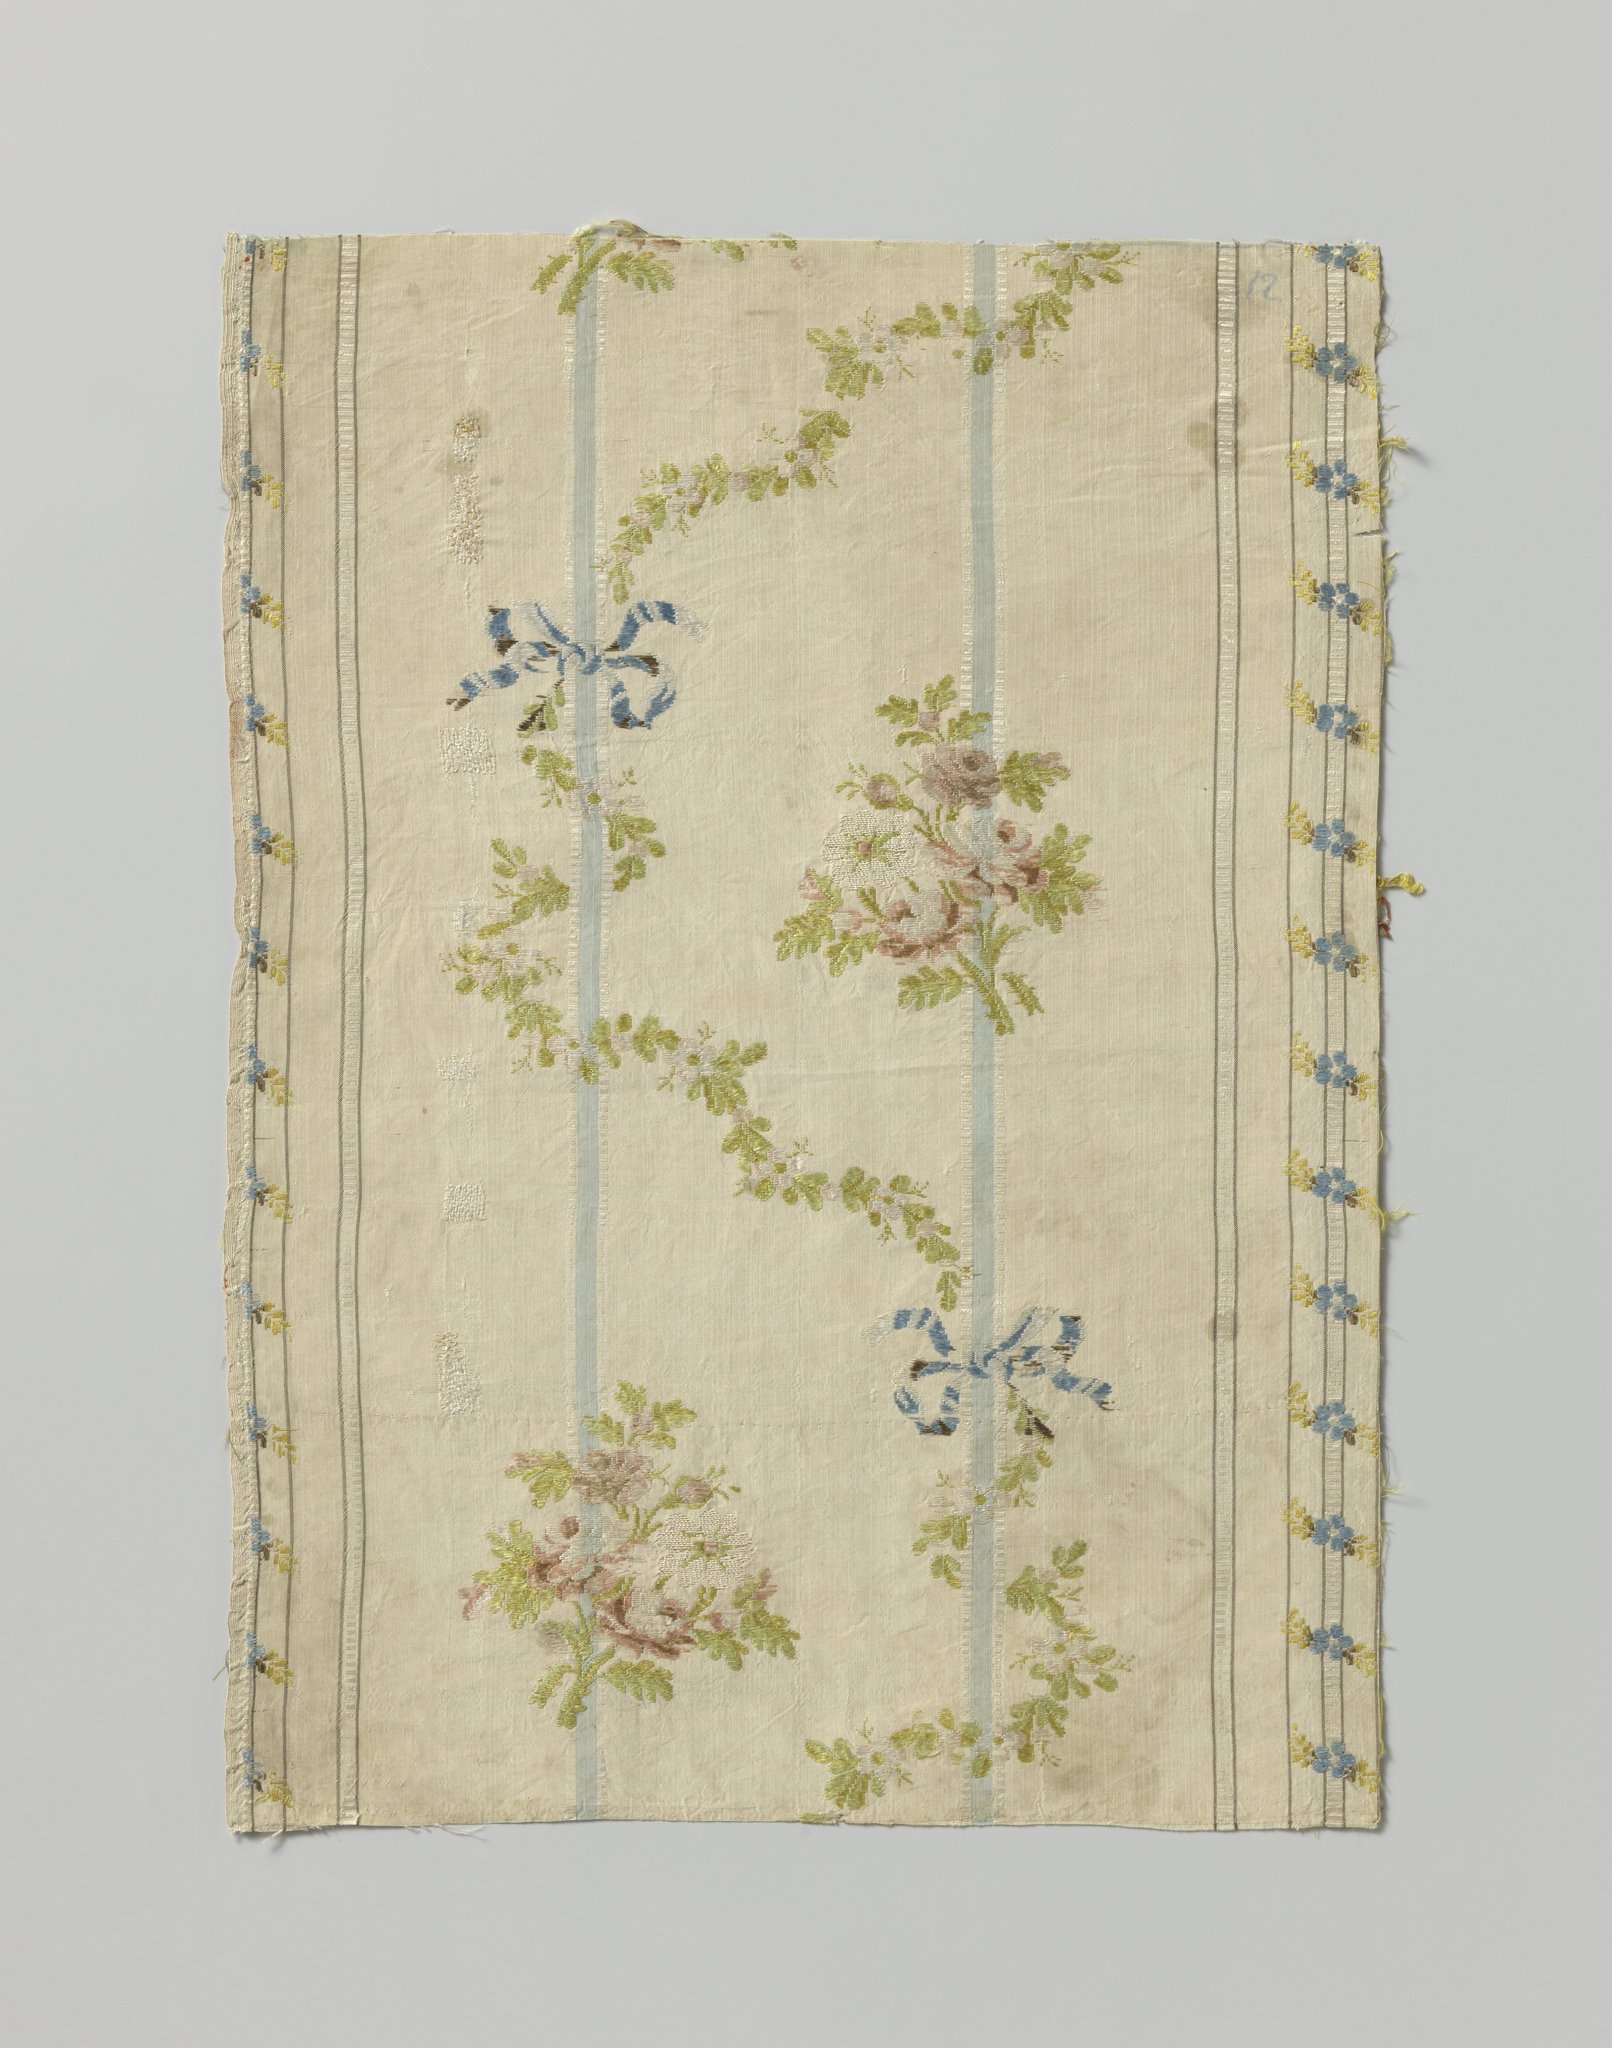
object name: fragment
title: Fragment veelkleurig zijden pekin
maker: Anonymous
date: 1750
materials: silk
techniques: brocade, gadrooning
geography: netherlands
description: Een fragment van blauw en wit gestreepte zijde, waarop gekleurde boeketten, strikken en slingers. Opmerking: Zelfkant; 0.4 cm, effenbinding.